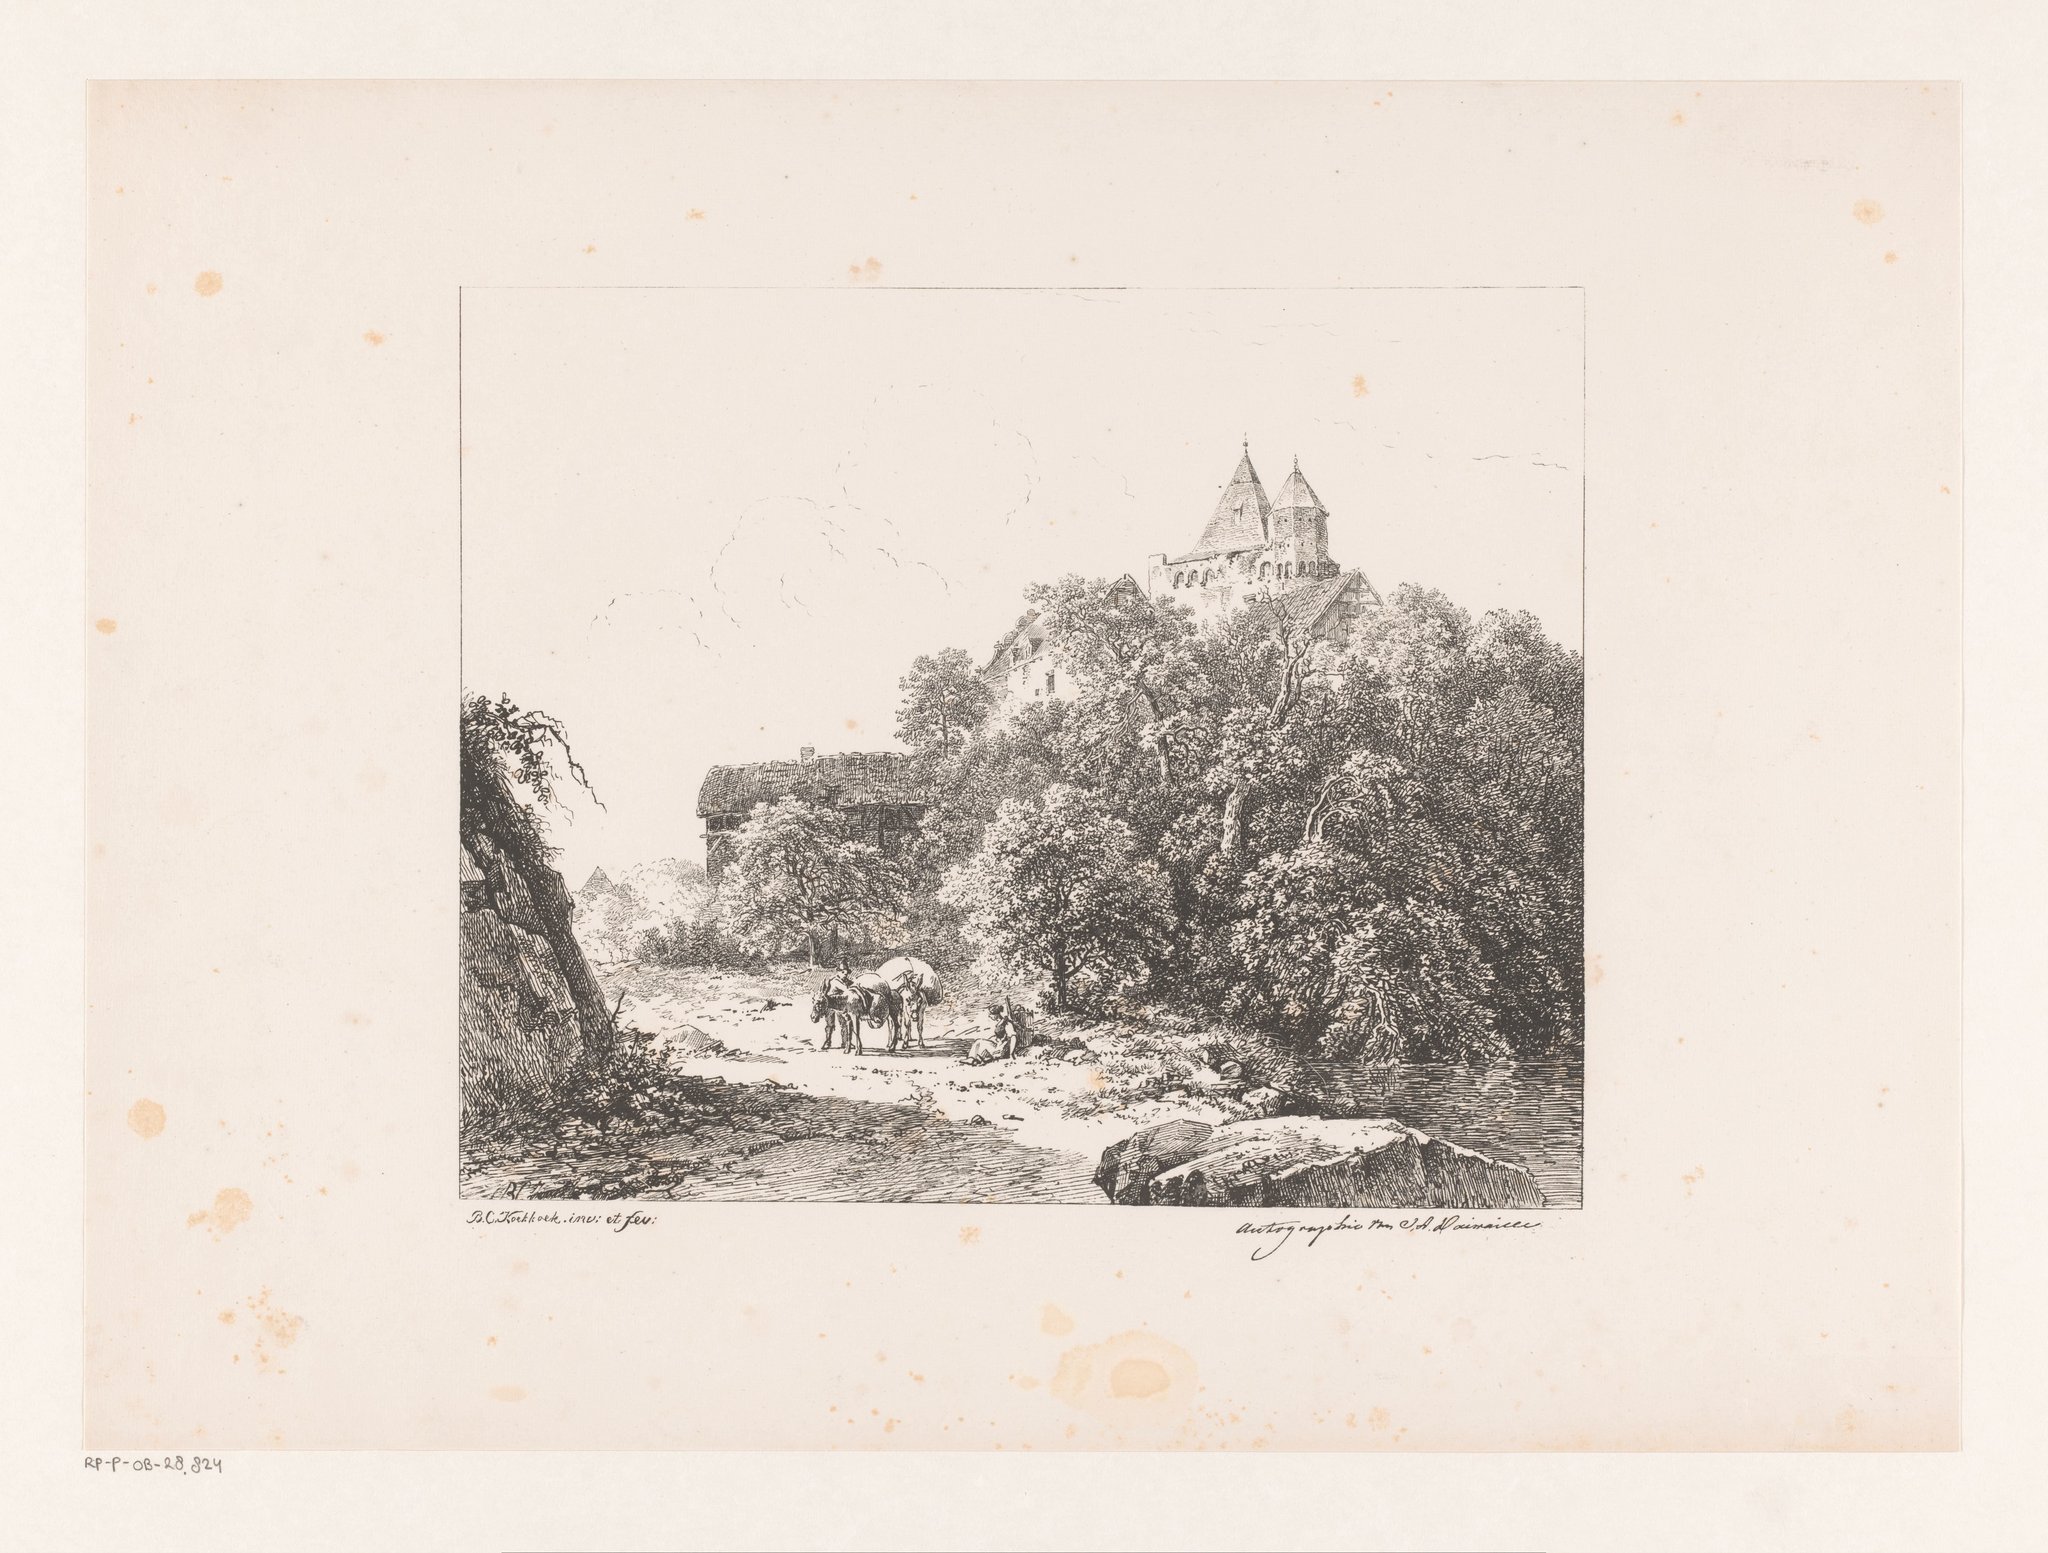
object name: print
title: Chateau Lansberg près de Ketwitch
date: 1820-1833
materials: paper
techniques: lithograph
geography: amsterdam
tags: castle, landscape with tower or castle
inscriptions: collector's mark: Lugt 2228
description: Het woord 'autographie' rechtsonder op de prent verwijst, volgens C. J. de Bruyn Kops in het Bulletin van het Rijksmuseum, naar een techniek waarbij op glad papier werd getekend. Deze tekening werd vervolgens op de steen overgebracht. Tot slot werd hiermee gedrukt. Dit had het effect dat de afbeelding niet in spiegelbeeld werd afgedrukt en de tekenaar dus ook niet in spiegelbeeld hoefde te werken.